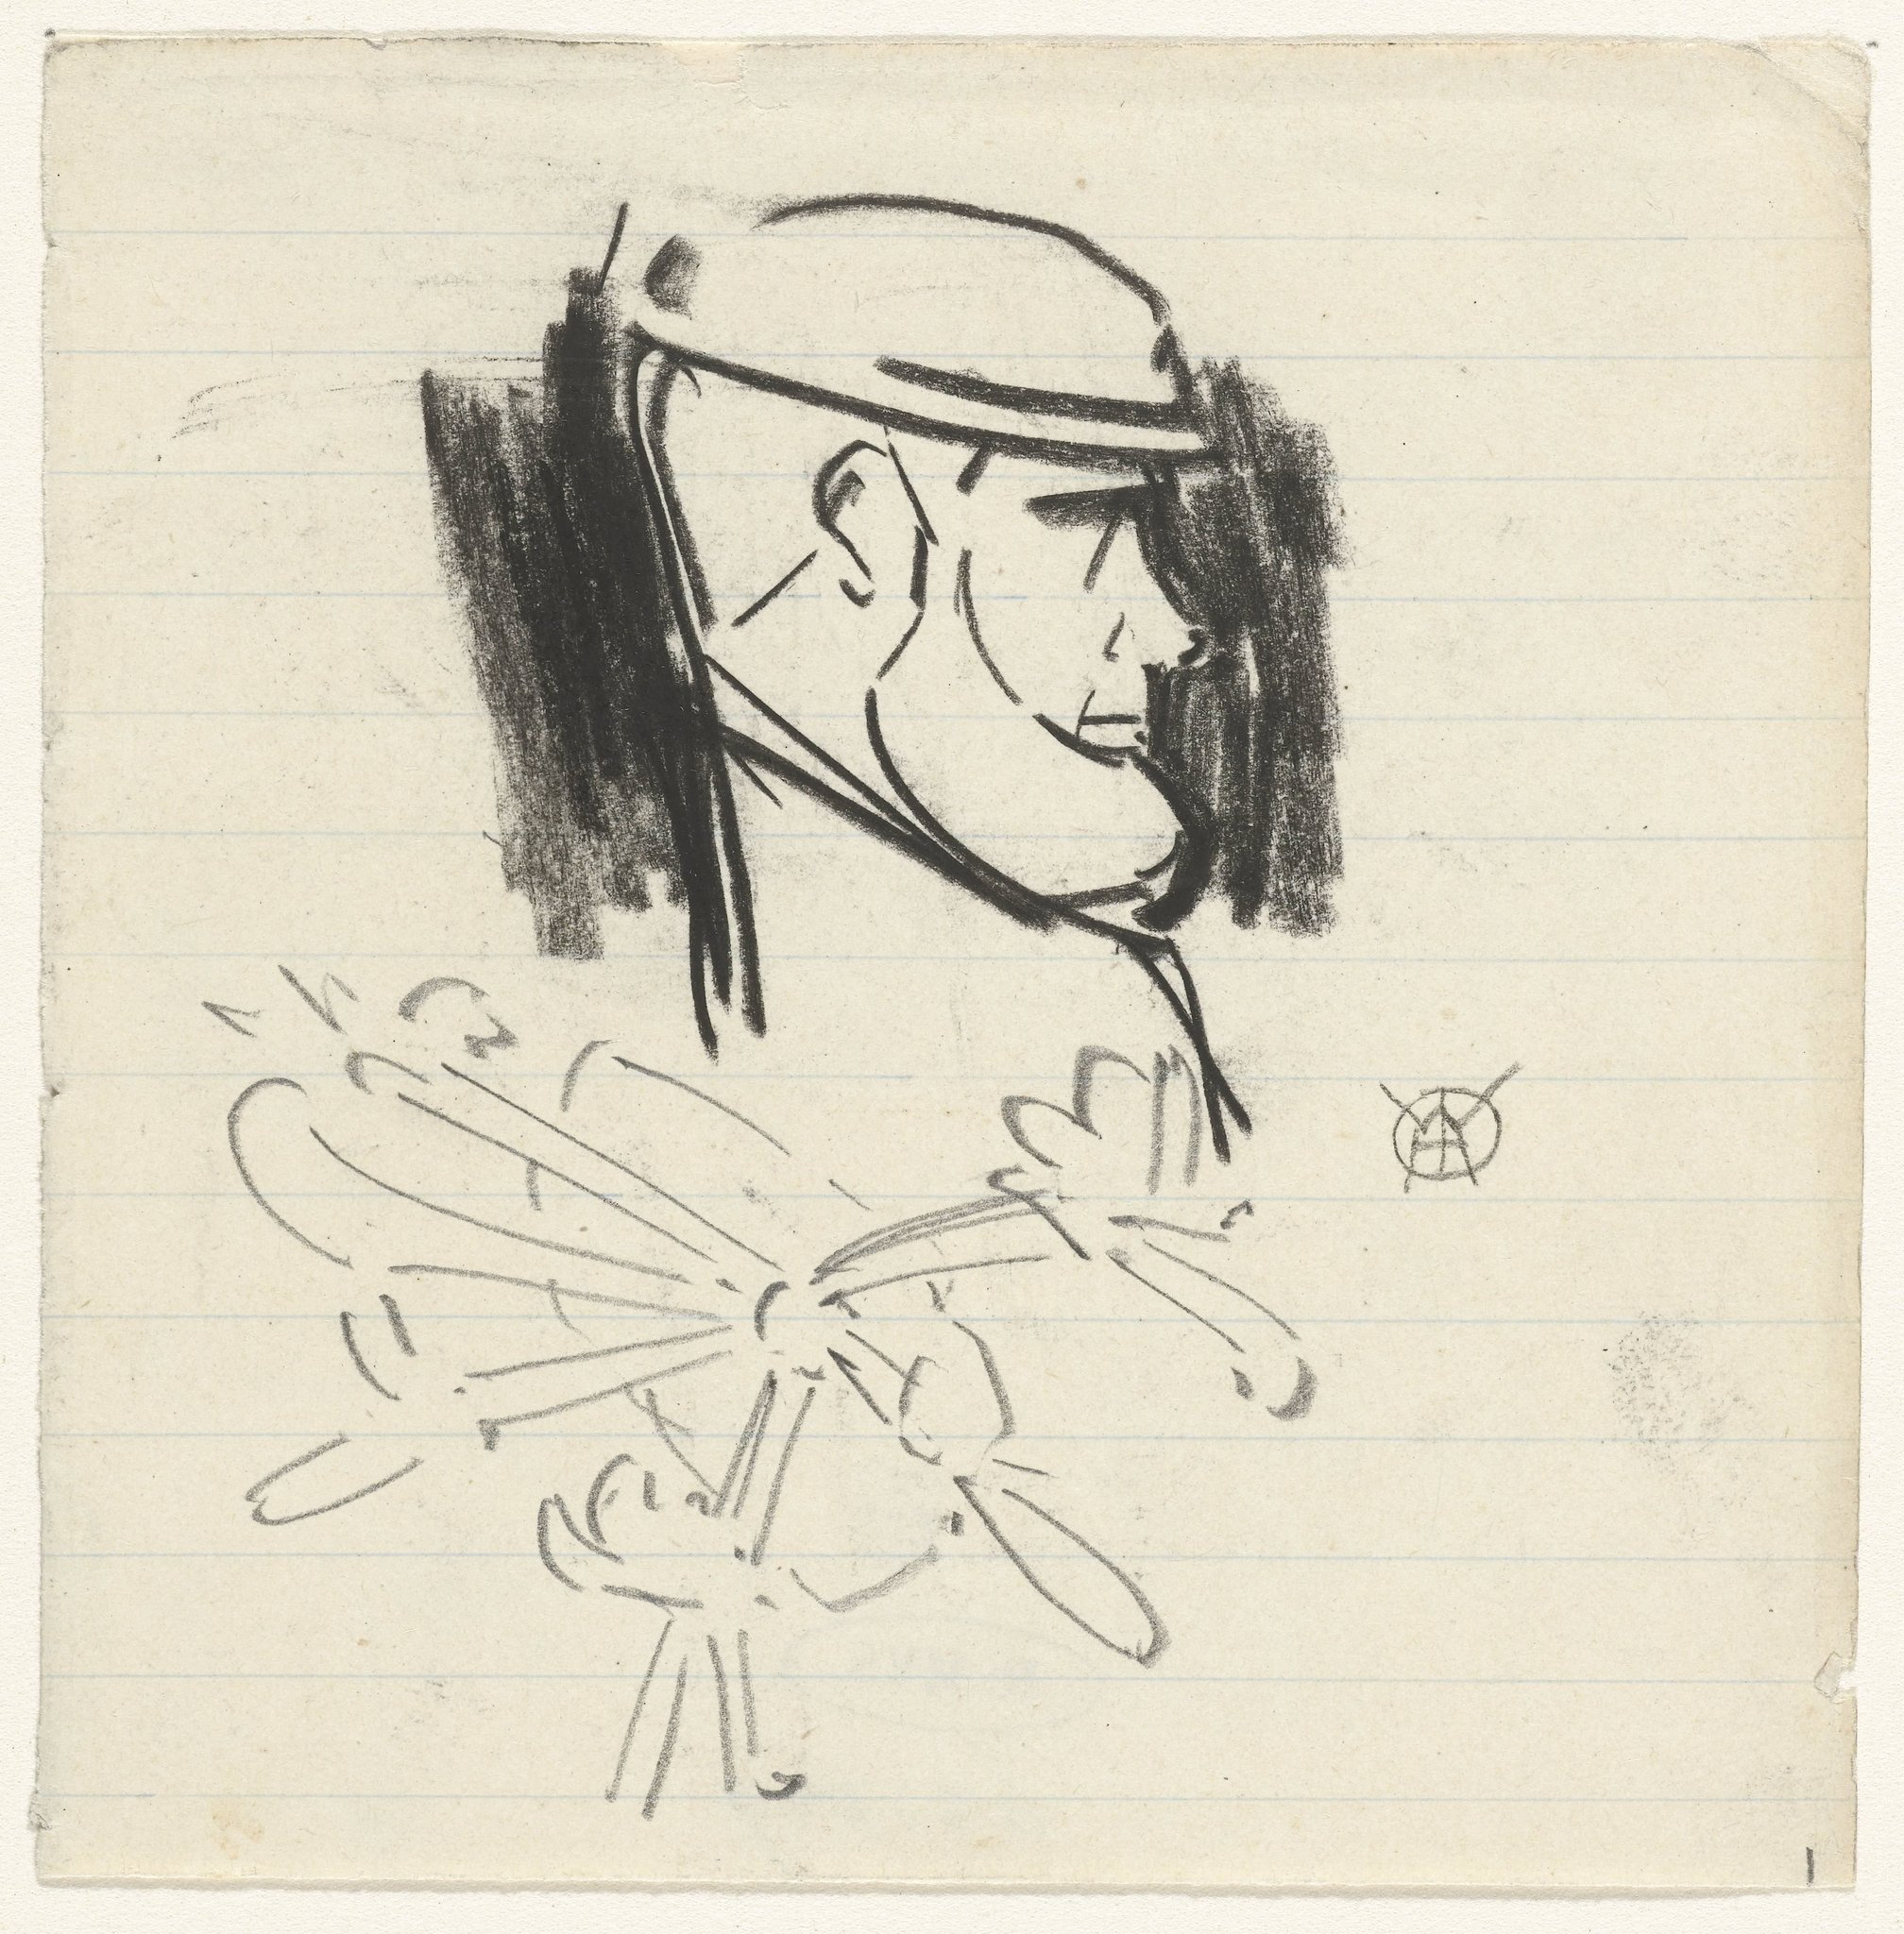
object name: drawing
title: Schets voor de bekroning van een leuning en kamperfoelie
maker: gerrit willem dijsselhof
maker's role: designer, draughtsman, print maker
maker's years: 1866-1924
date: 1876-1924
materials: chalk, paper, pencil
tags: flowers: honeysuckle